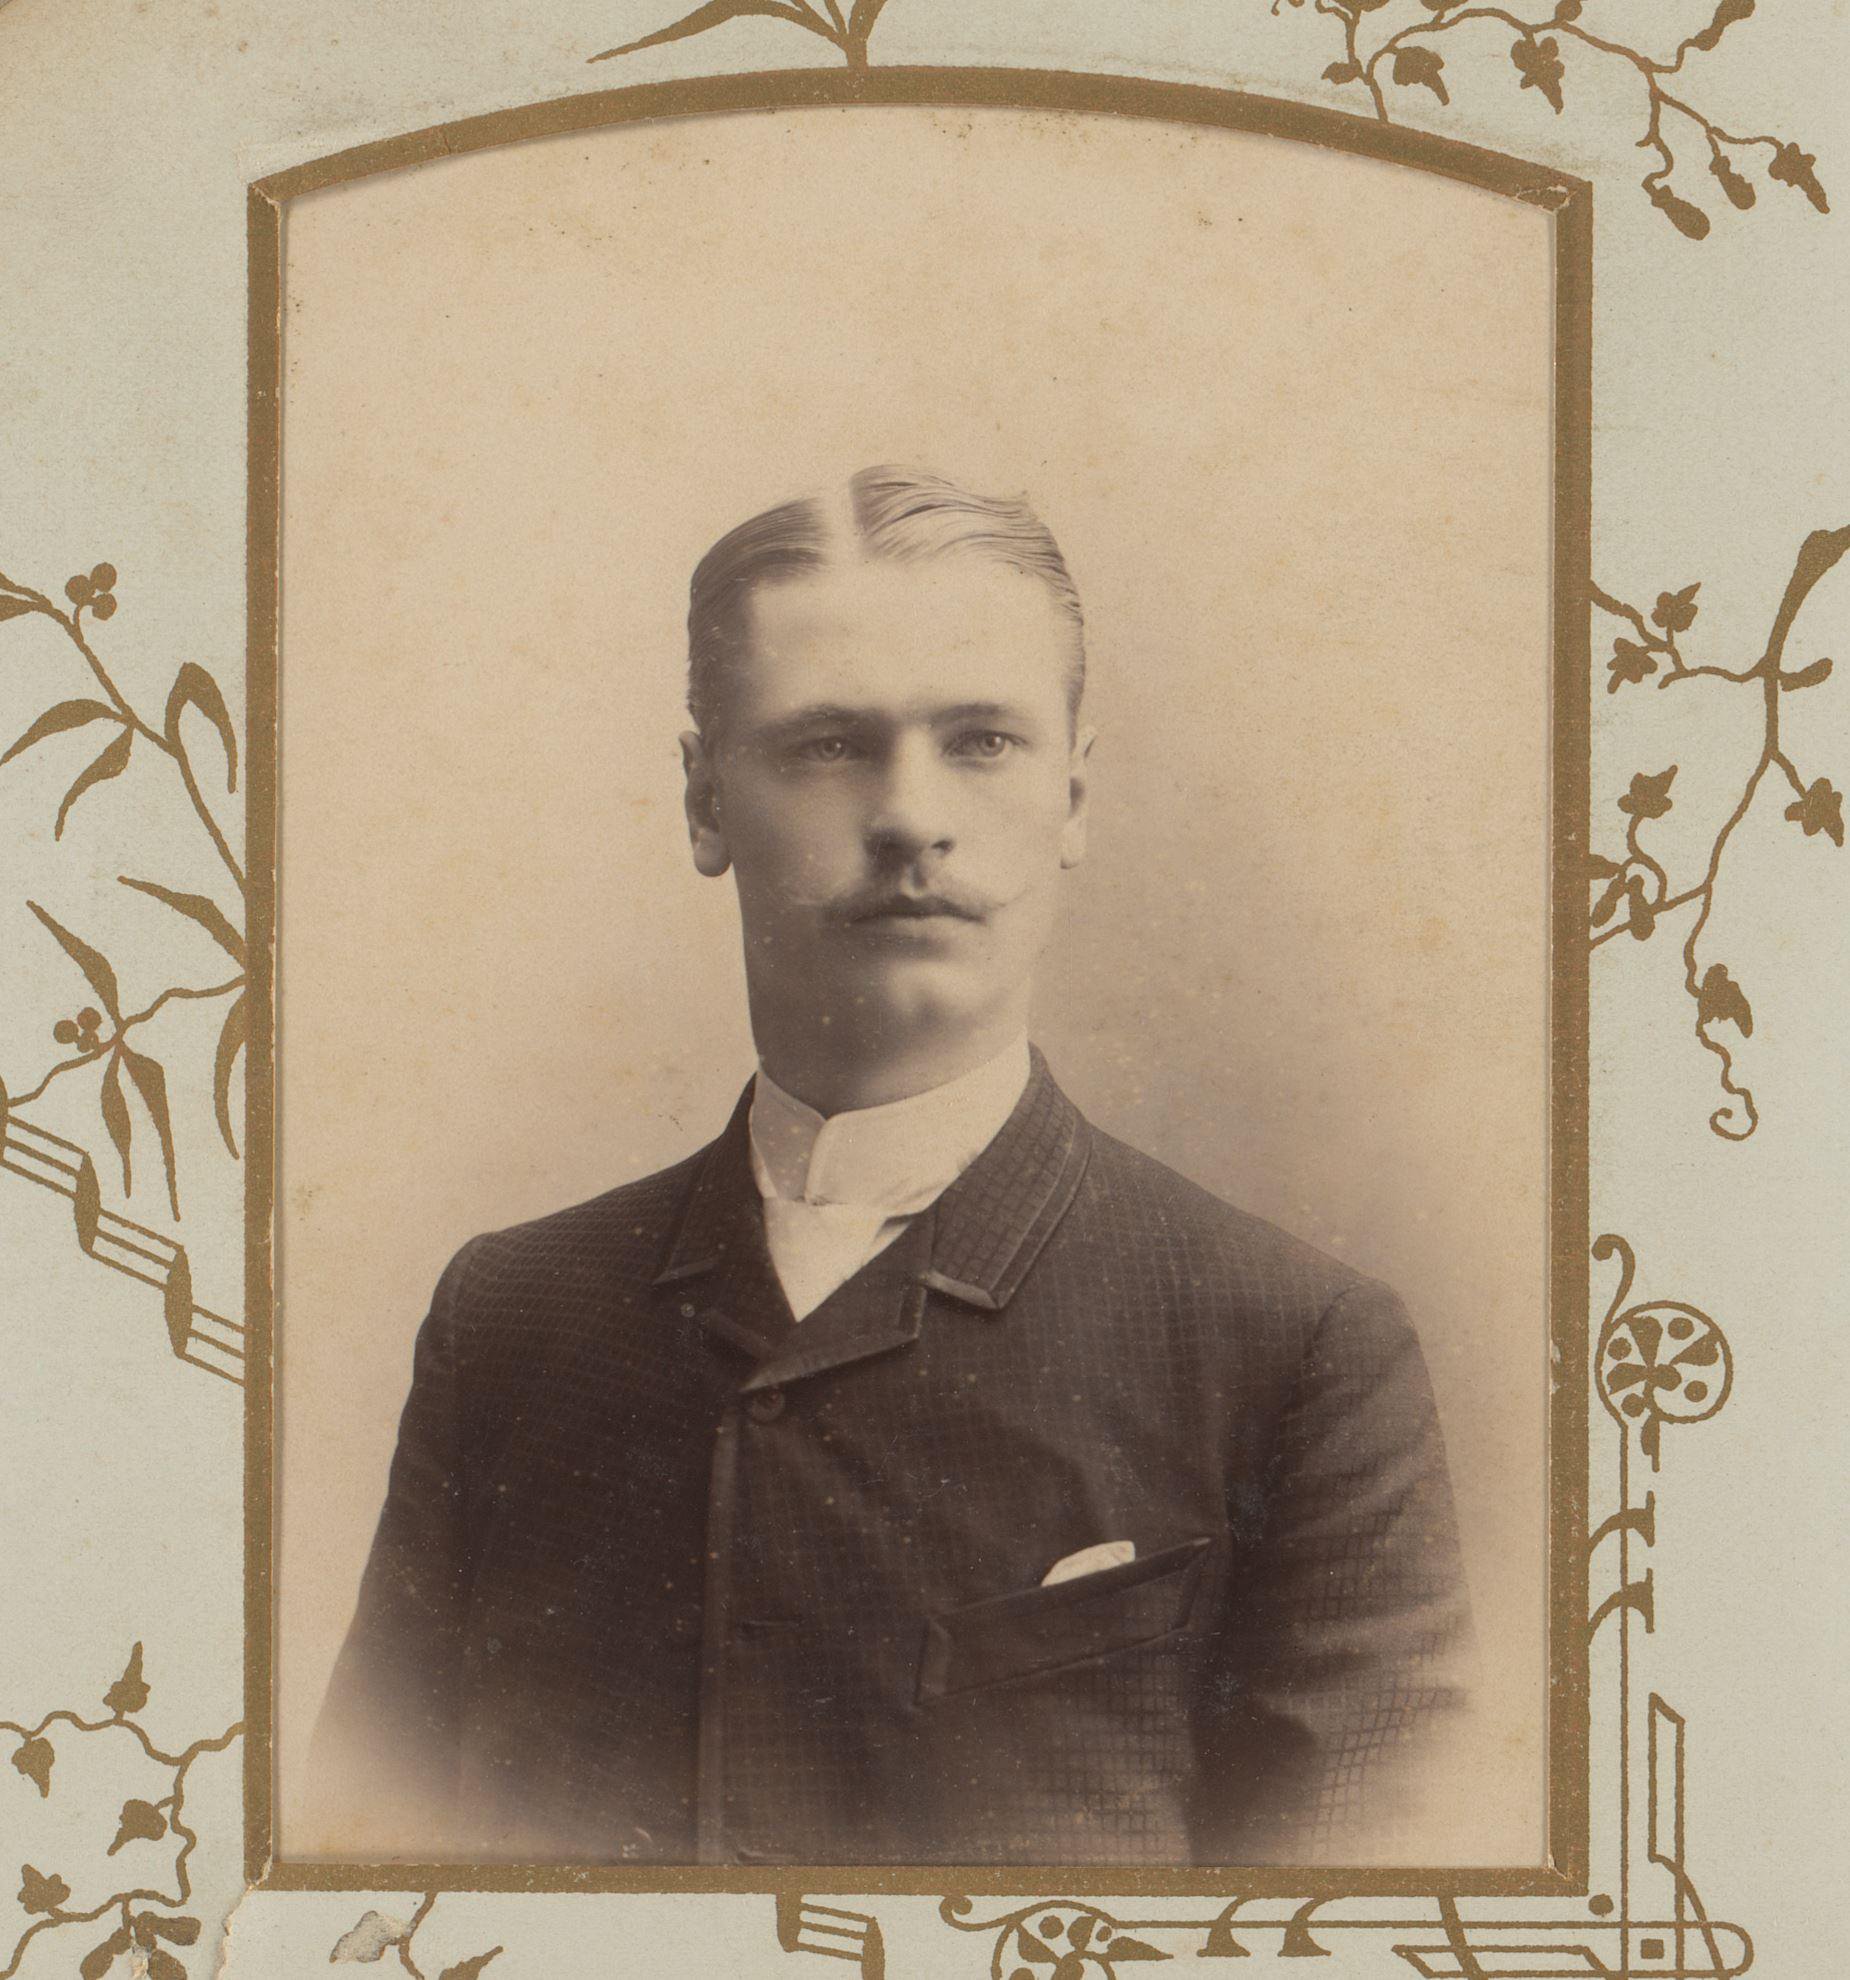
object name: album leaf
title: Portret van een man met snor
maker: heinrich gerdom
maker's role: fotograaf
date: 1860-1900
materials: cardboard, photographic support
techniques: albumen print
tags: moustache, adult man, historical persons